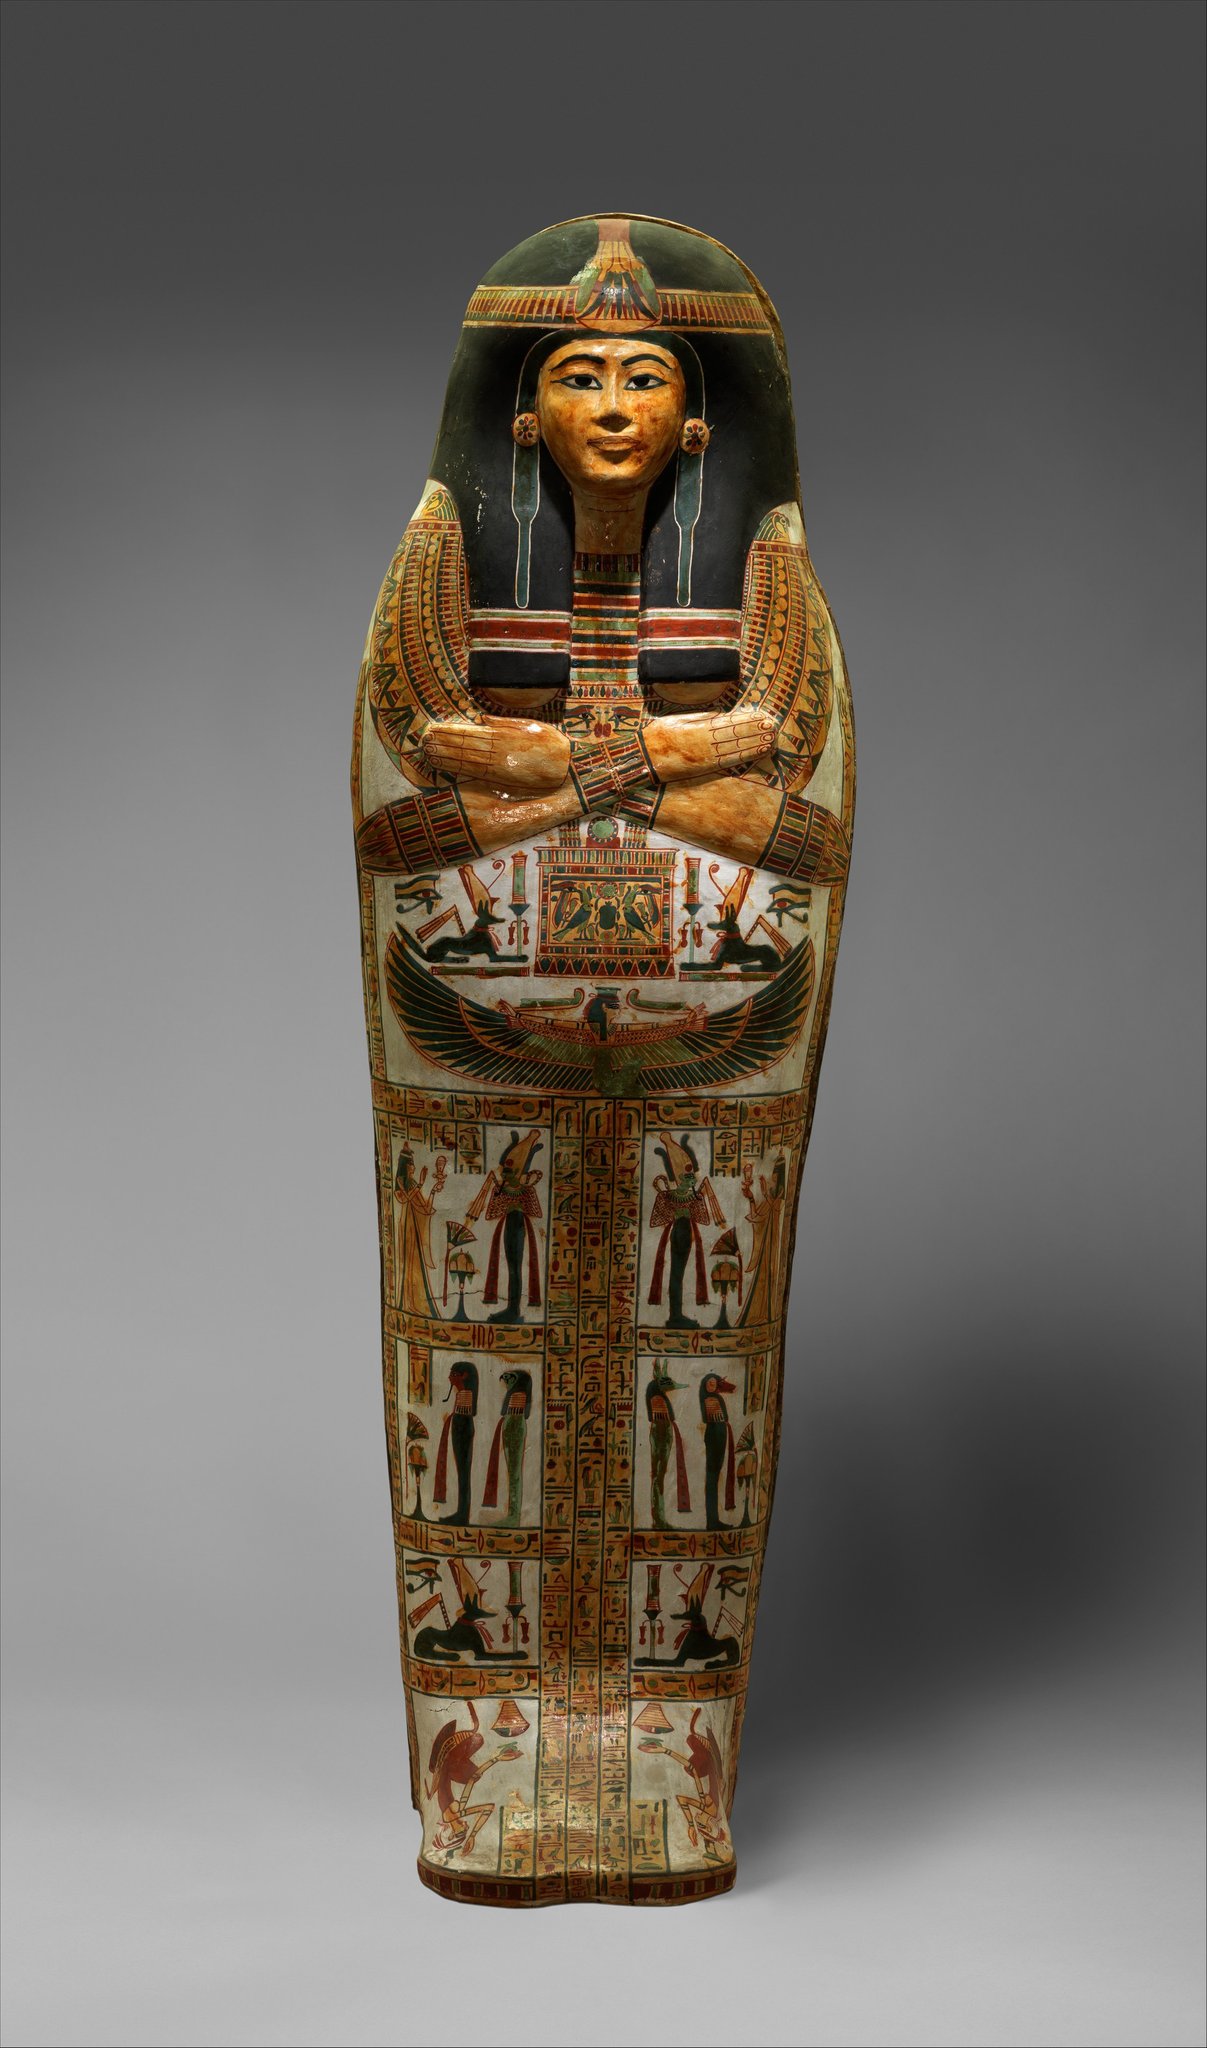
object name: coffin, singer of amun re, henettawy f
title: Outer Coffin of the Chantress of Amun-Re Henettawy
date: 1000-945 BCE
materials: gesso, paint, varnish, wood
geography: egypt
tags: hieroglyphs,anubis,horus,isis,coffins,d21-coffins